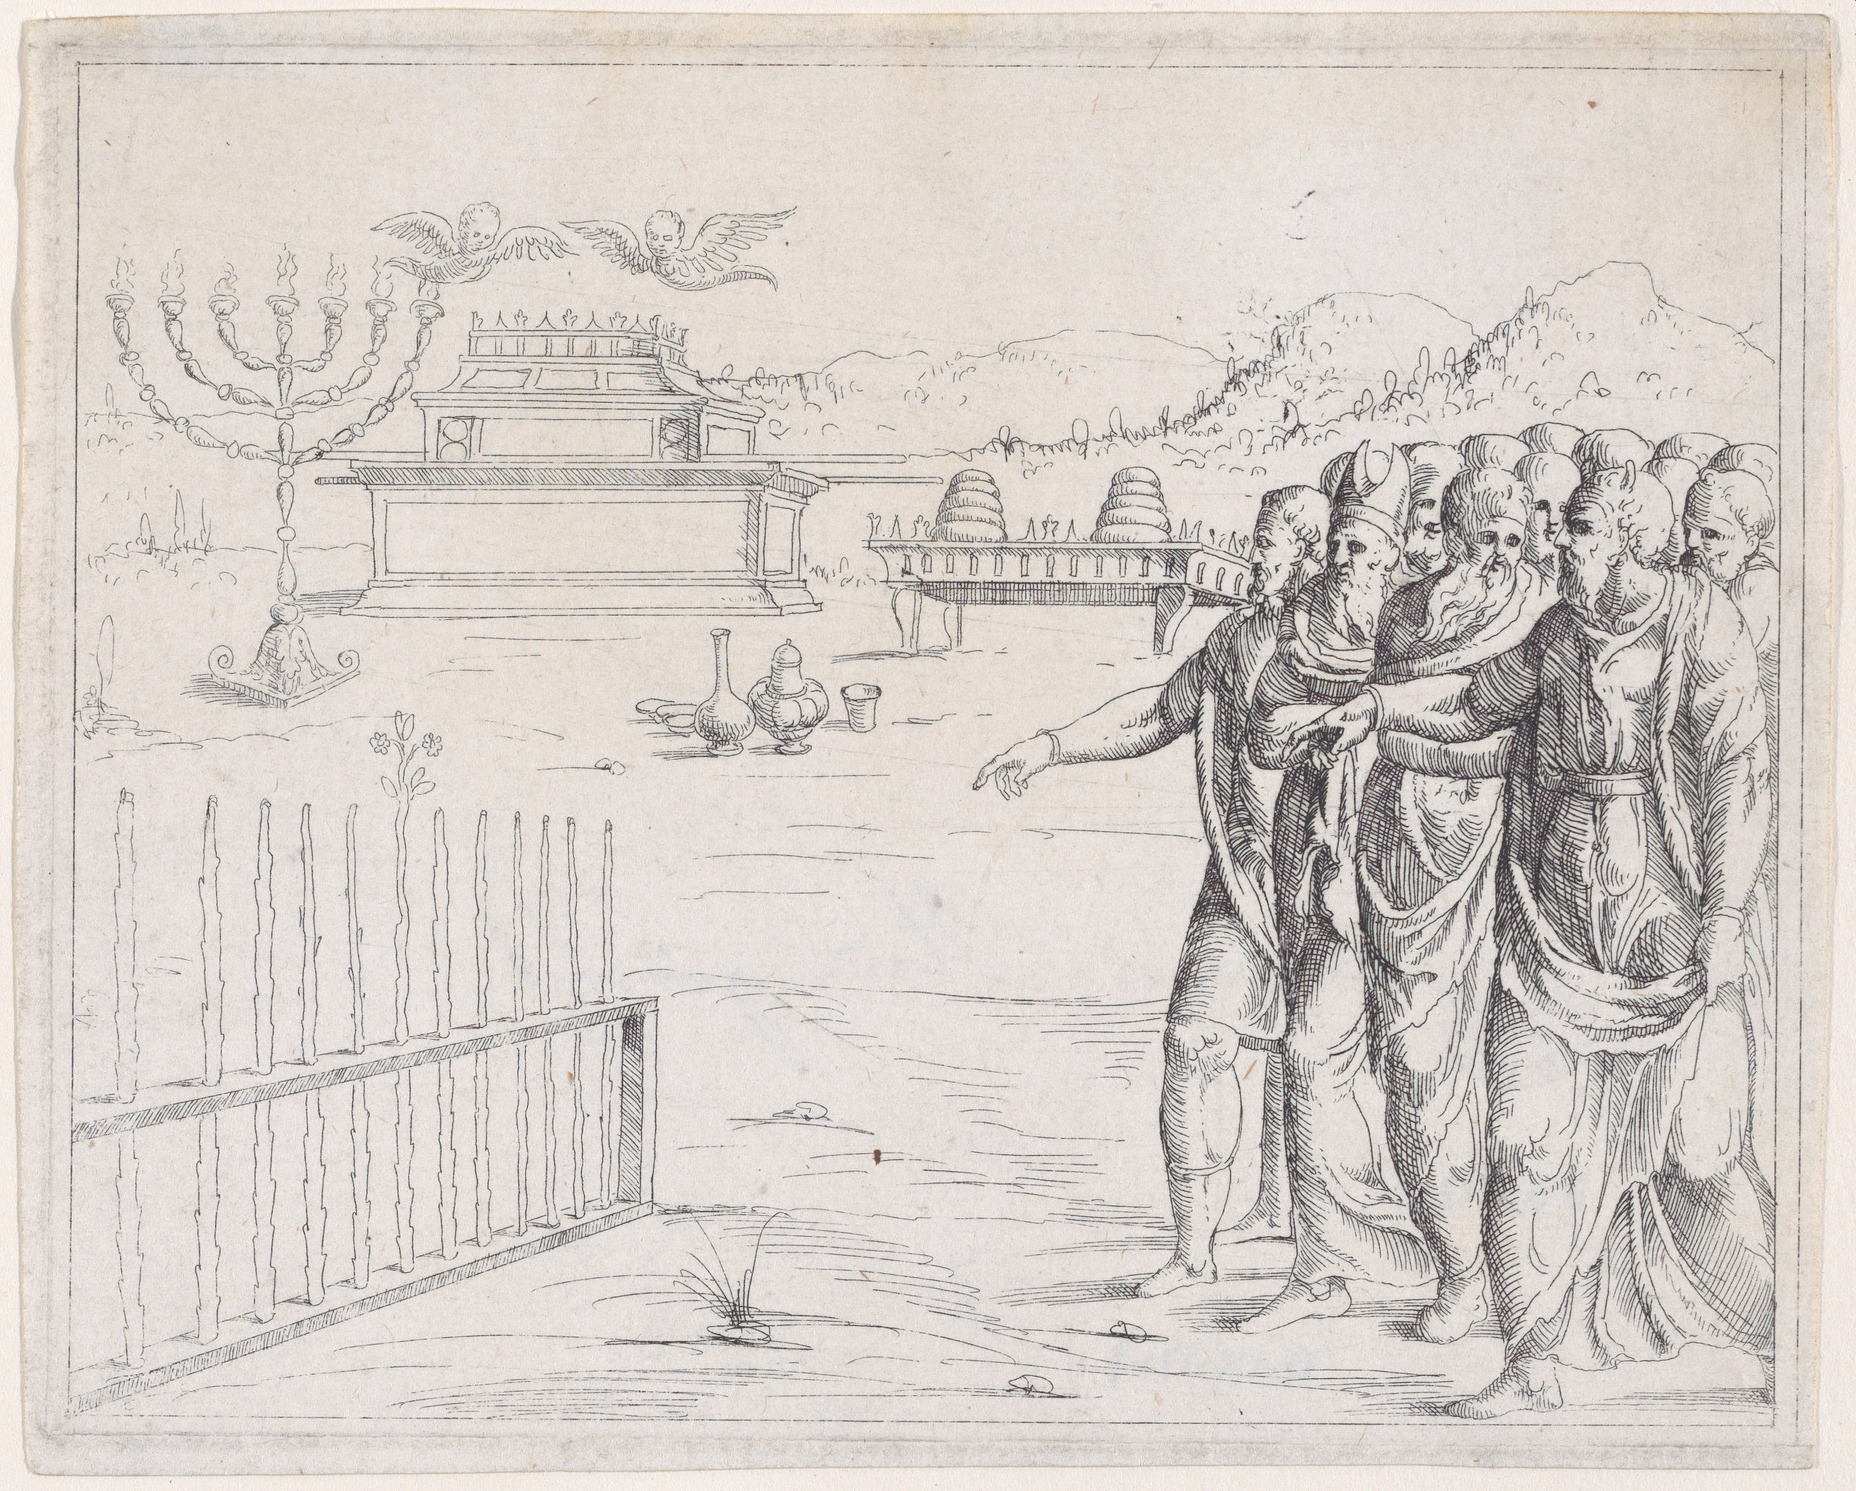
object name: print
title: The Blossoming of Aaron's Rod, from Old and New Testaments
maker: augustin hirschvogel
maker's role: artist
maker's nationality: german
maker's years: 1503-1553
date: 1550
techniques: etching